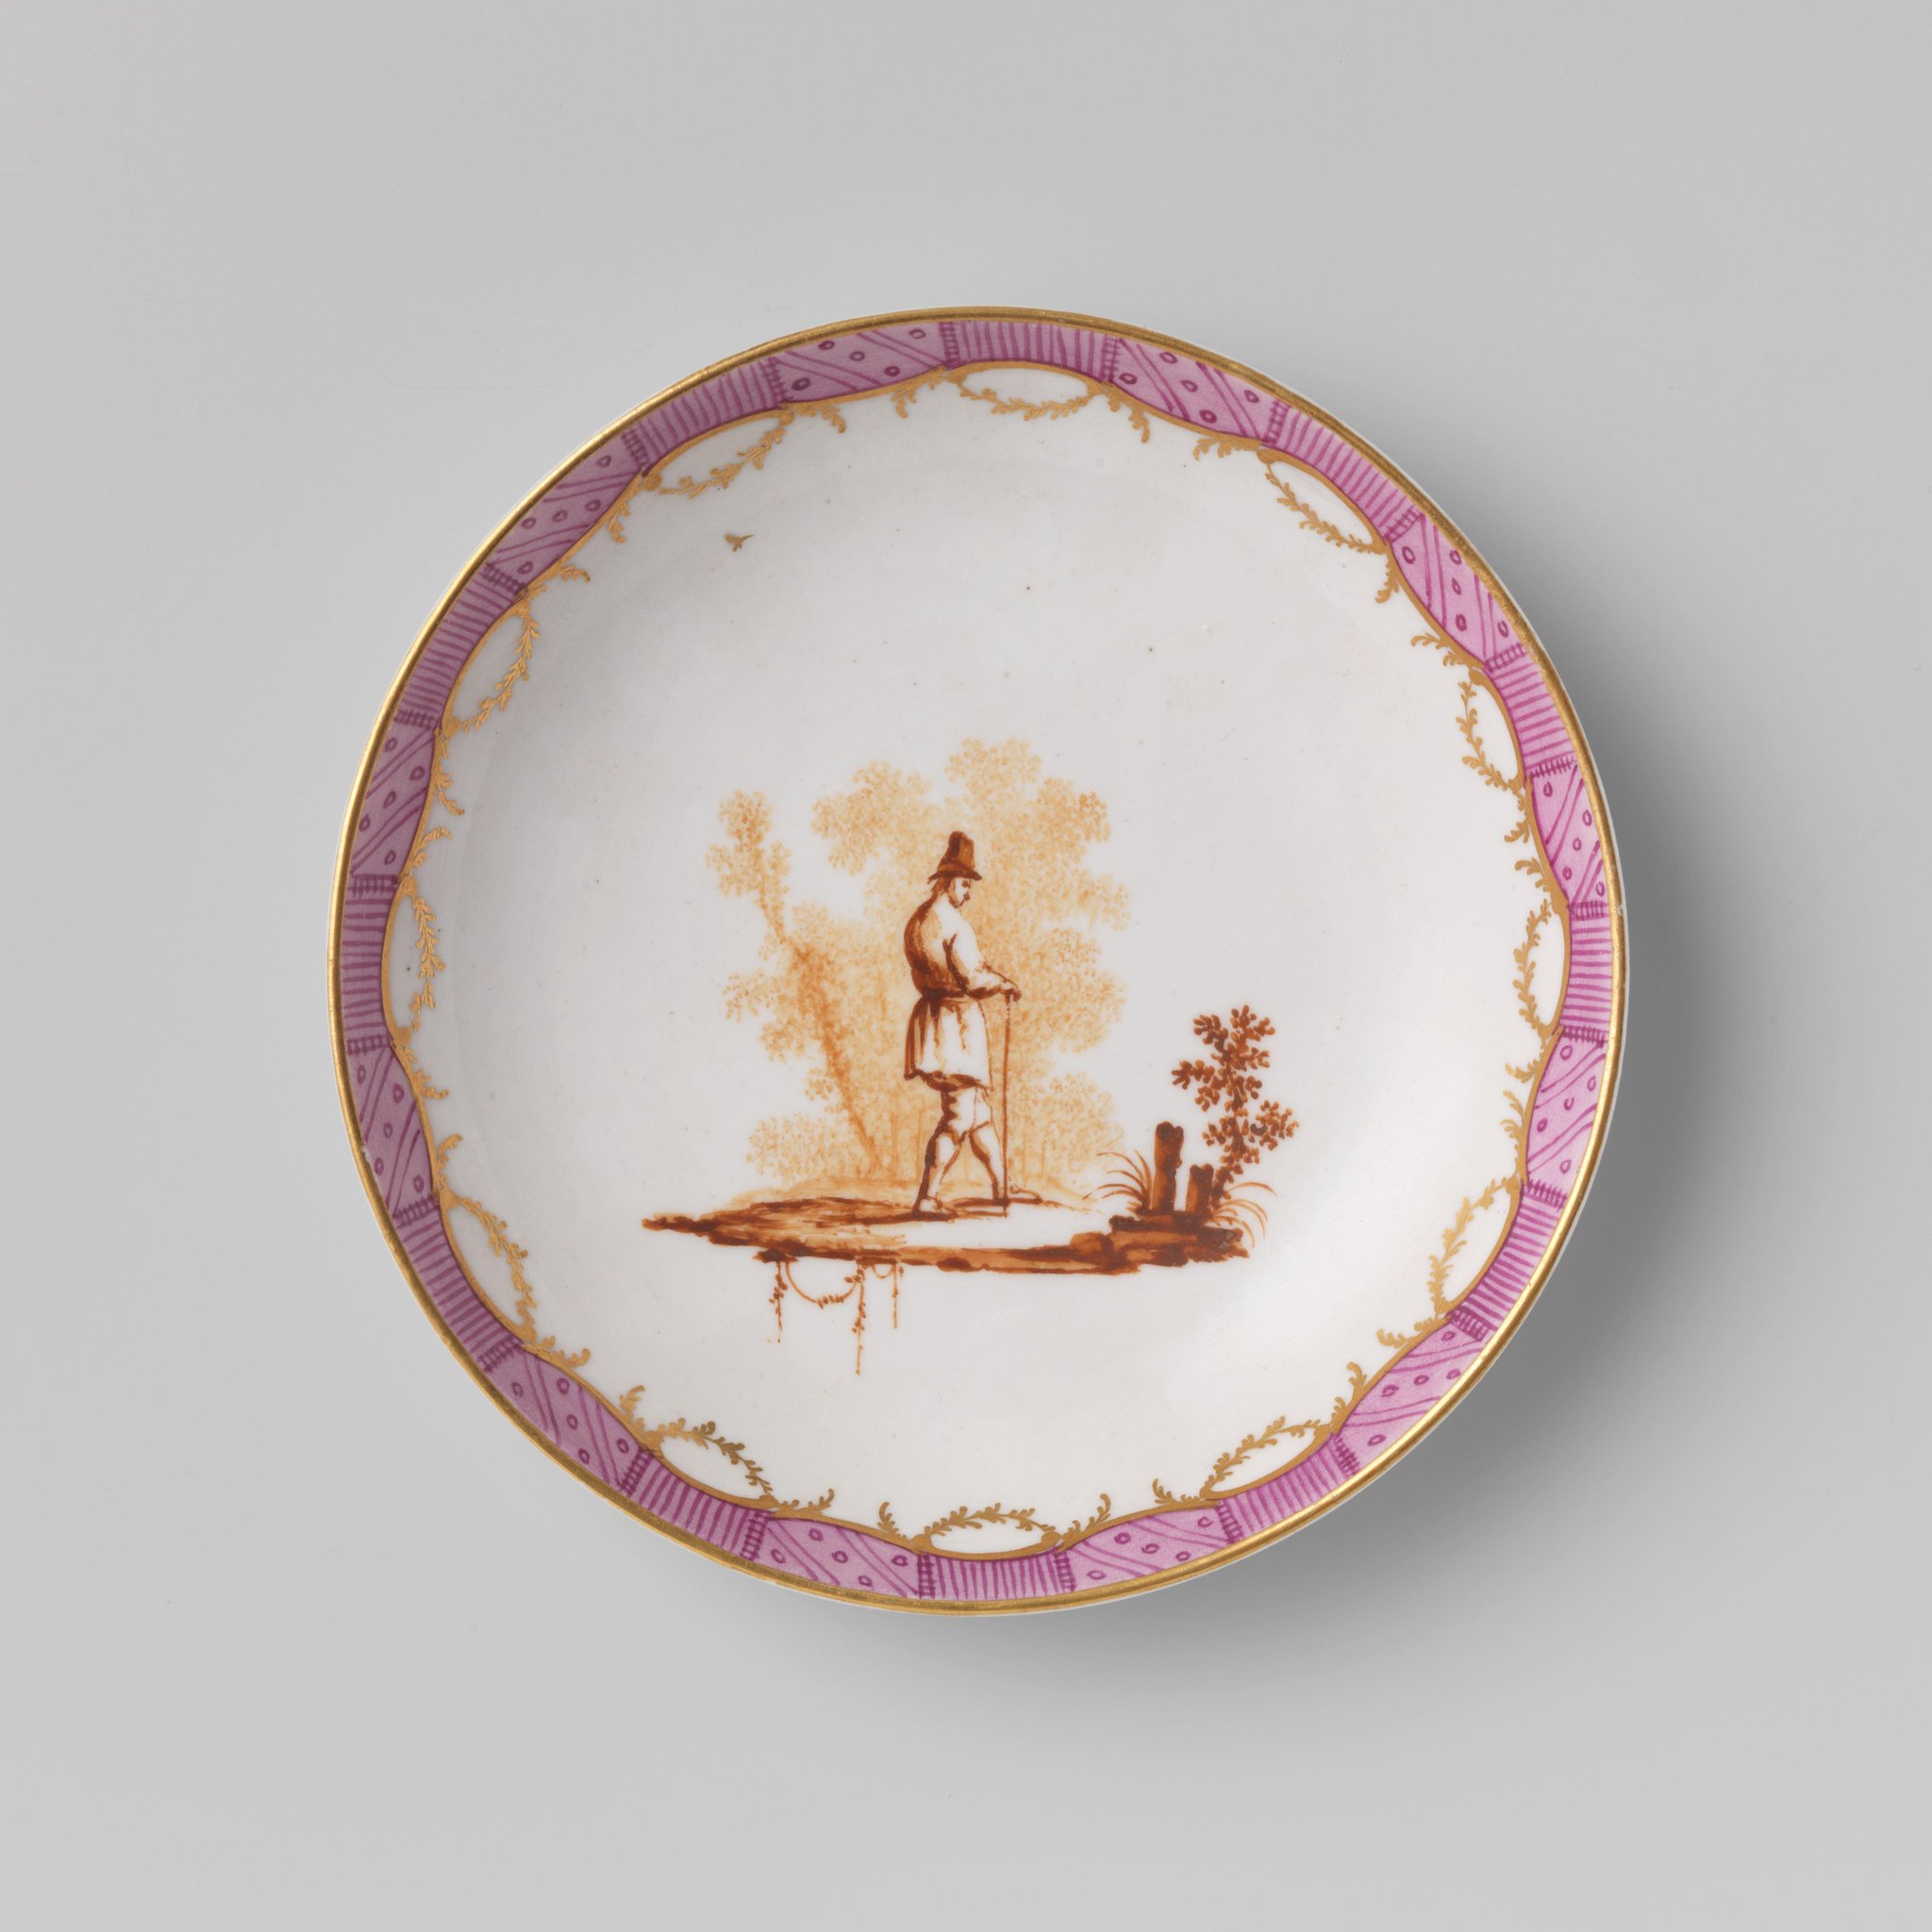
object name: platter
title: Schotel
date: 1774-1778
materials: porcelain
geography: loosdrecht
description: Schotel van porselein. Beschilderd in sepia met figuren in een landschap. Langs de rand een lila fries tussen gouden biezen.